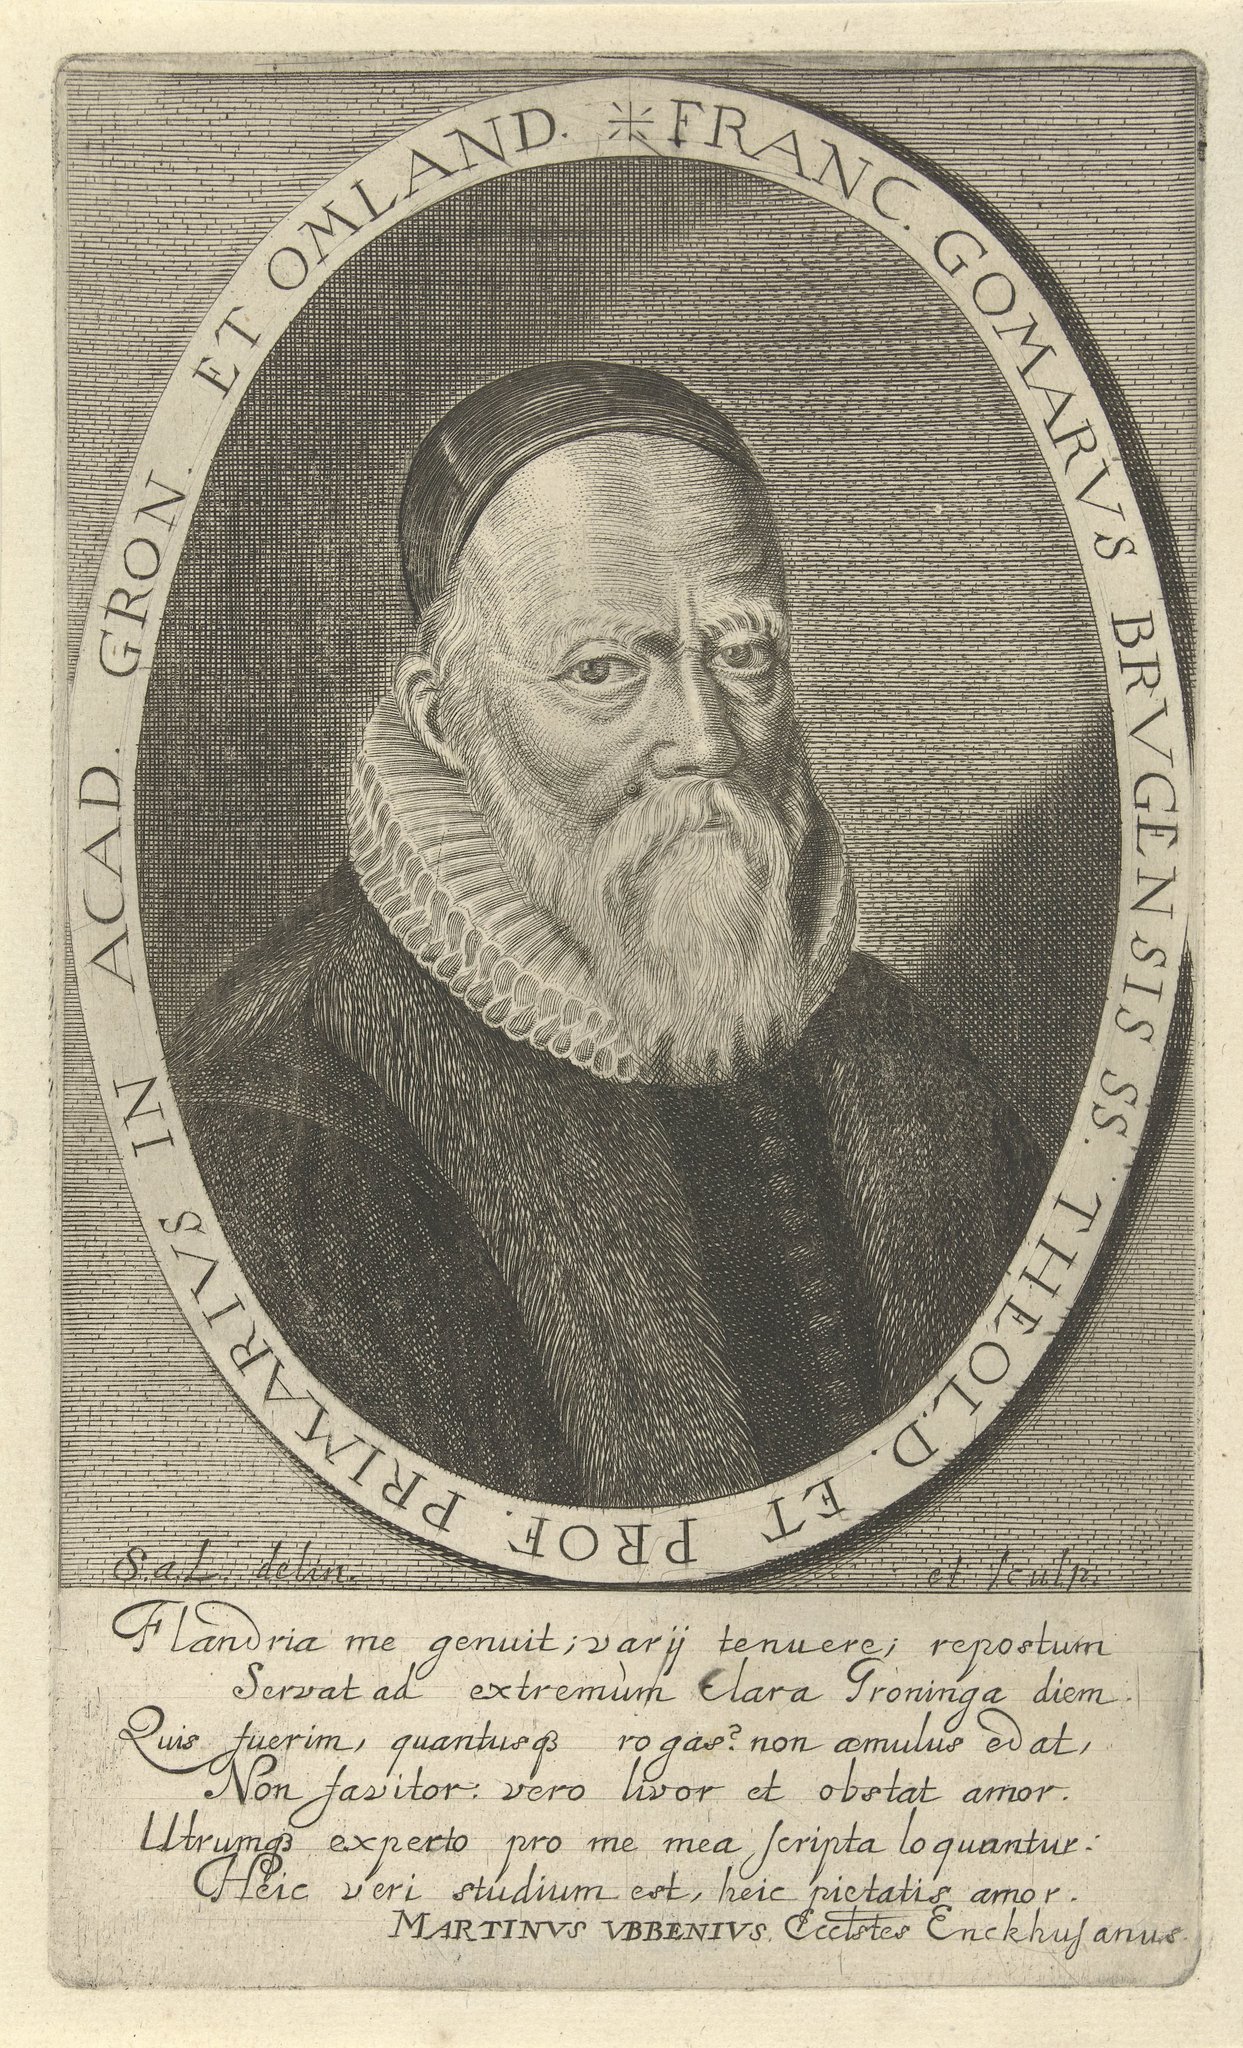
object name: print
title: Portret van Franciscus Gomarus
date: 1654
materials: paper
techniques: engraving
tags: bruges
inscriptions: collector's mark: Lugt 2228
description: Portretbuste in ovaal naar rechts van Franciscus Gomarus, hoogleraar in de theologie te Groningen, met kalot. Op de ovale omlijsting staat een randschrift in Latijn, in de marge een zesregelig Latijns vers.